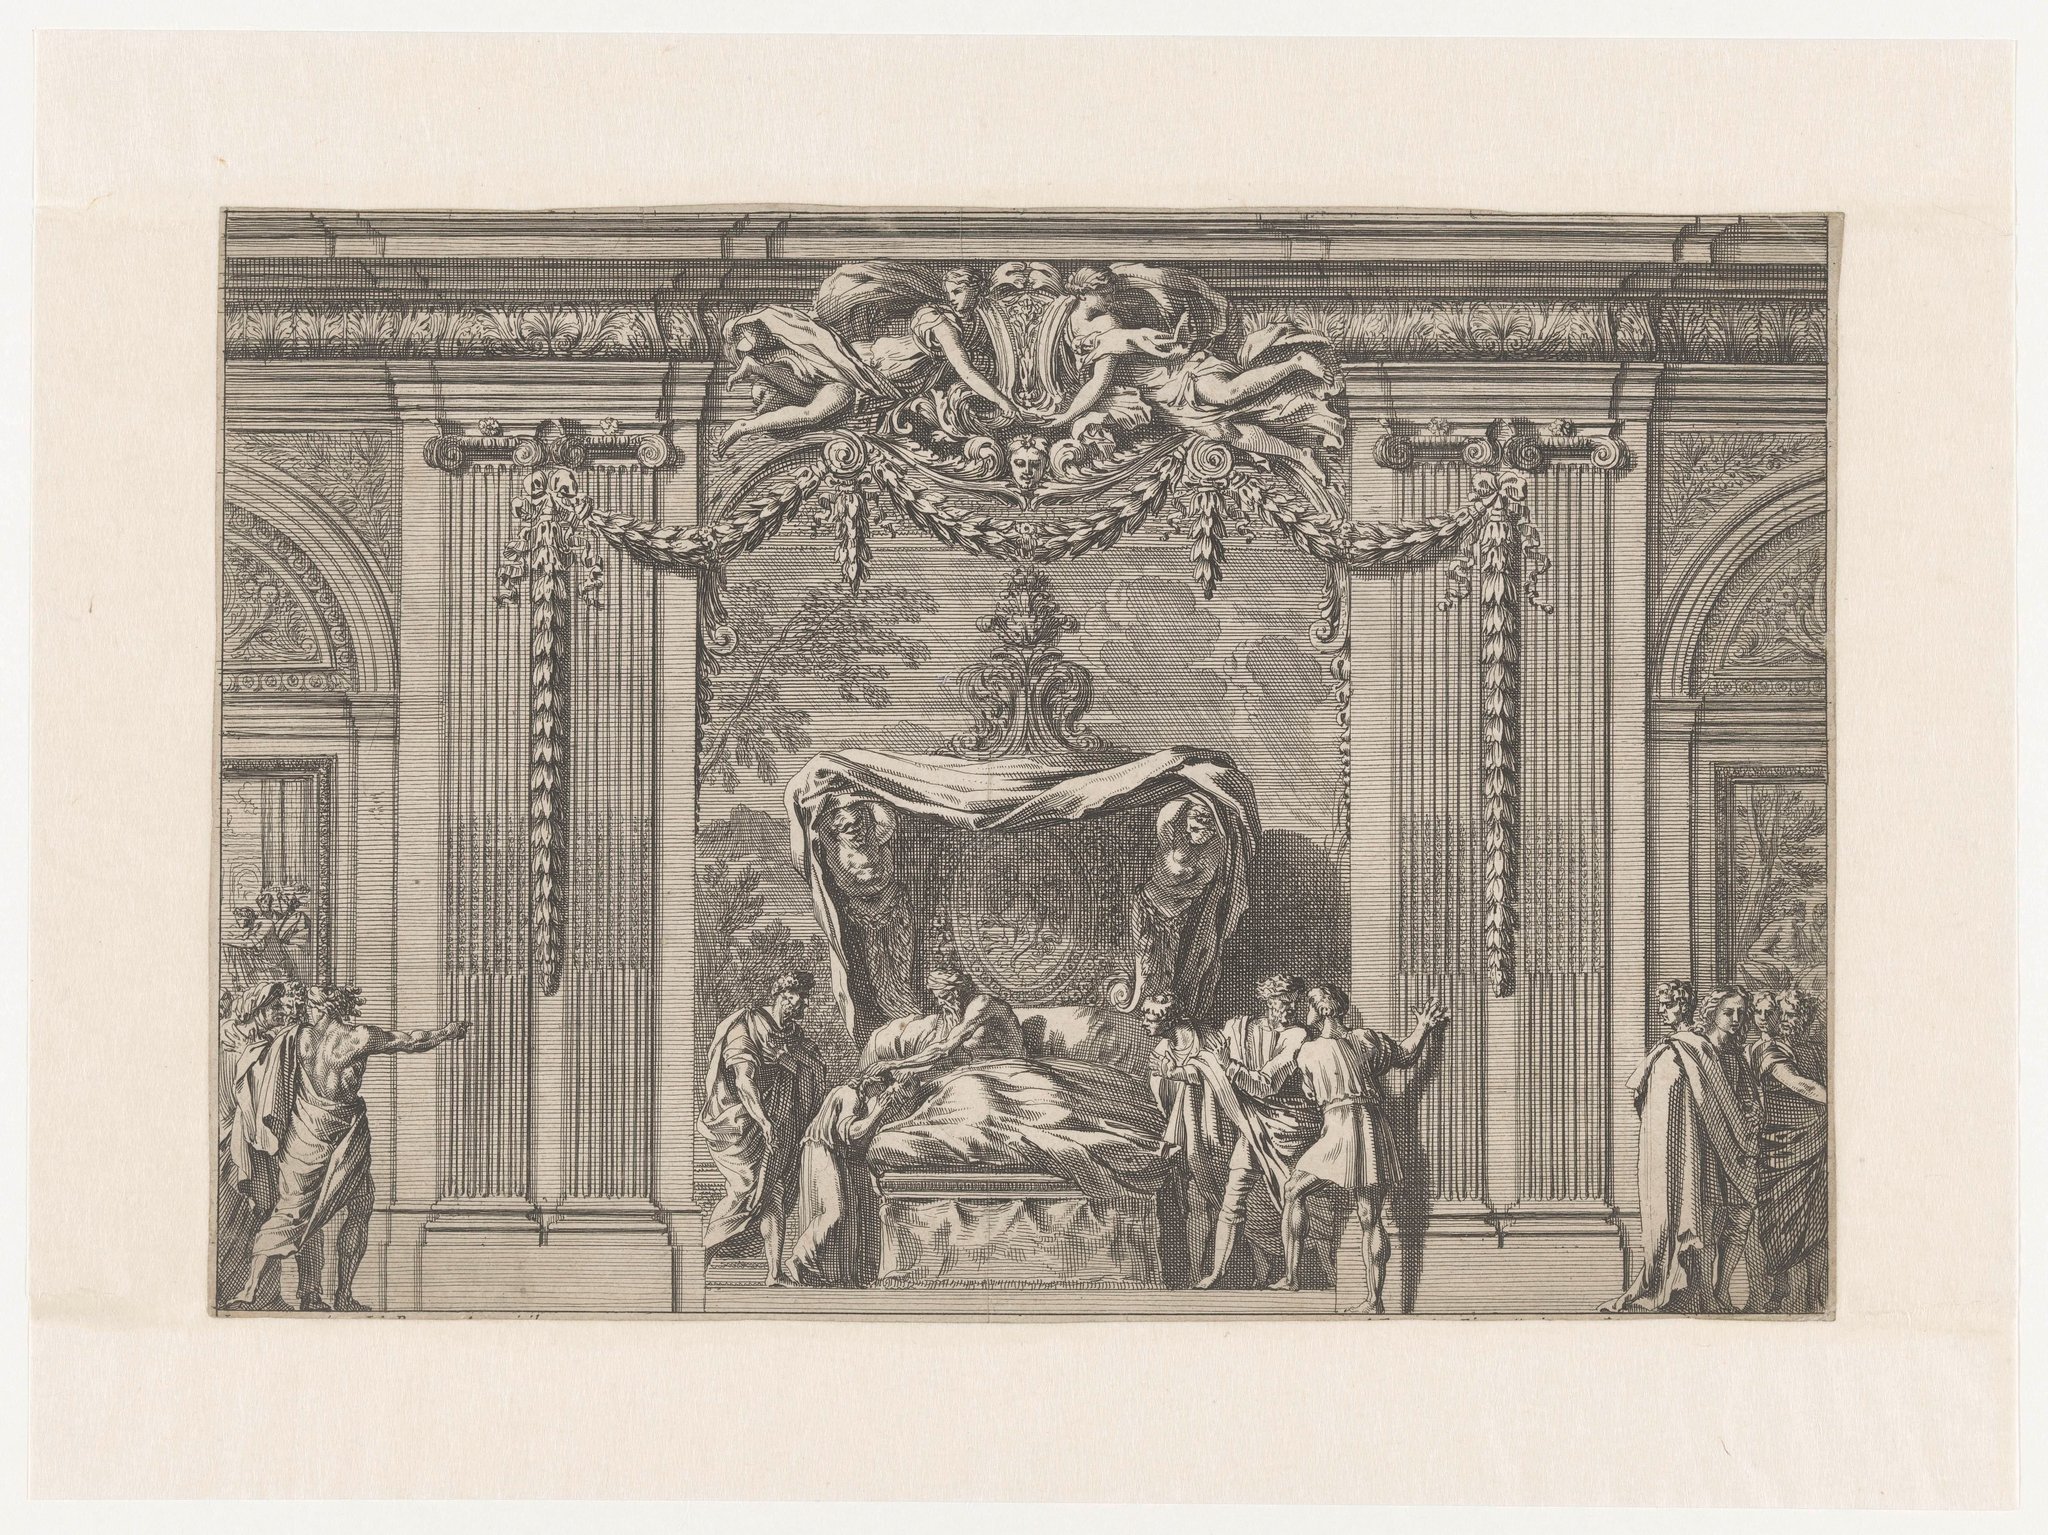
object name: print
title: Oeuvres D'Architecture de Jean Le Pautre (...) Tome Second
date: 1667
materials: paper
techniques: etching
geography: paris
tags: jacob blesses manasseh and ephraim with arms uncrossed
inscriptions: collector's mark: Lugt 2228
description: Op zijn sterfbed spreekt Jakob zijn zegen uit over Efraïm en Manasse, de kinderen van zijn zoon Josef. De armen van Jakob zijn niet gekruist. Links en rechts kijken omstanders toe.